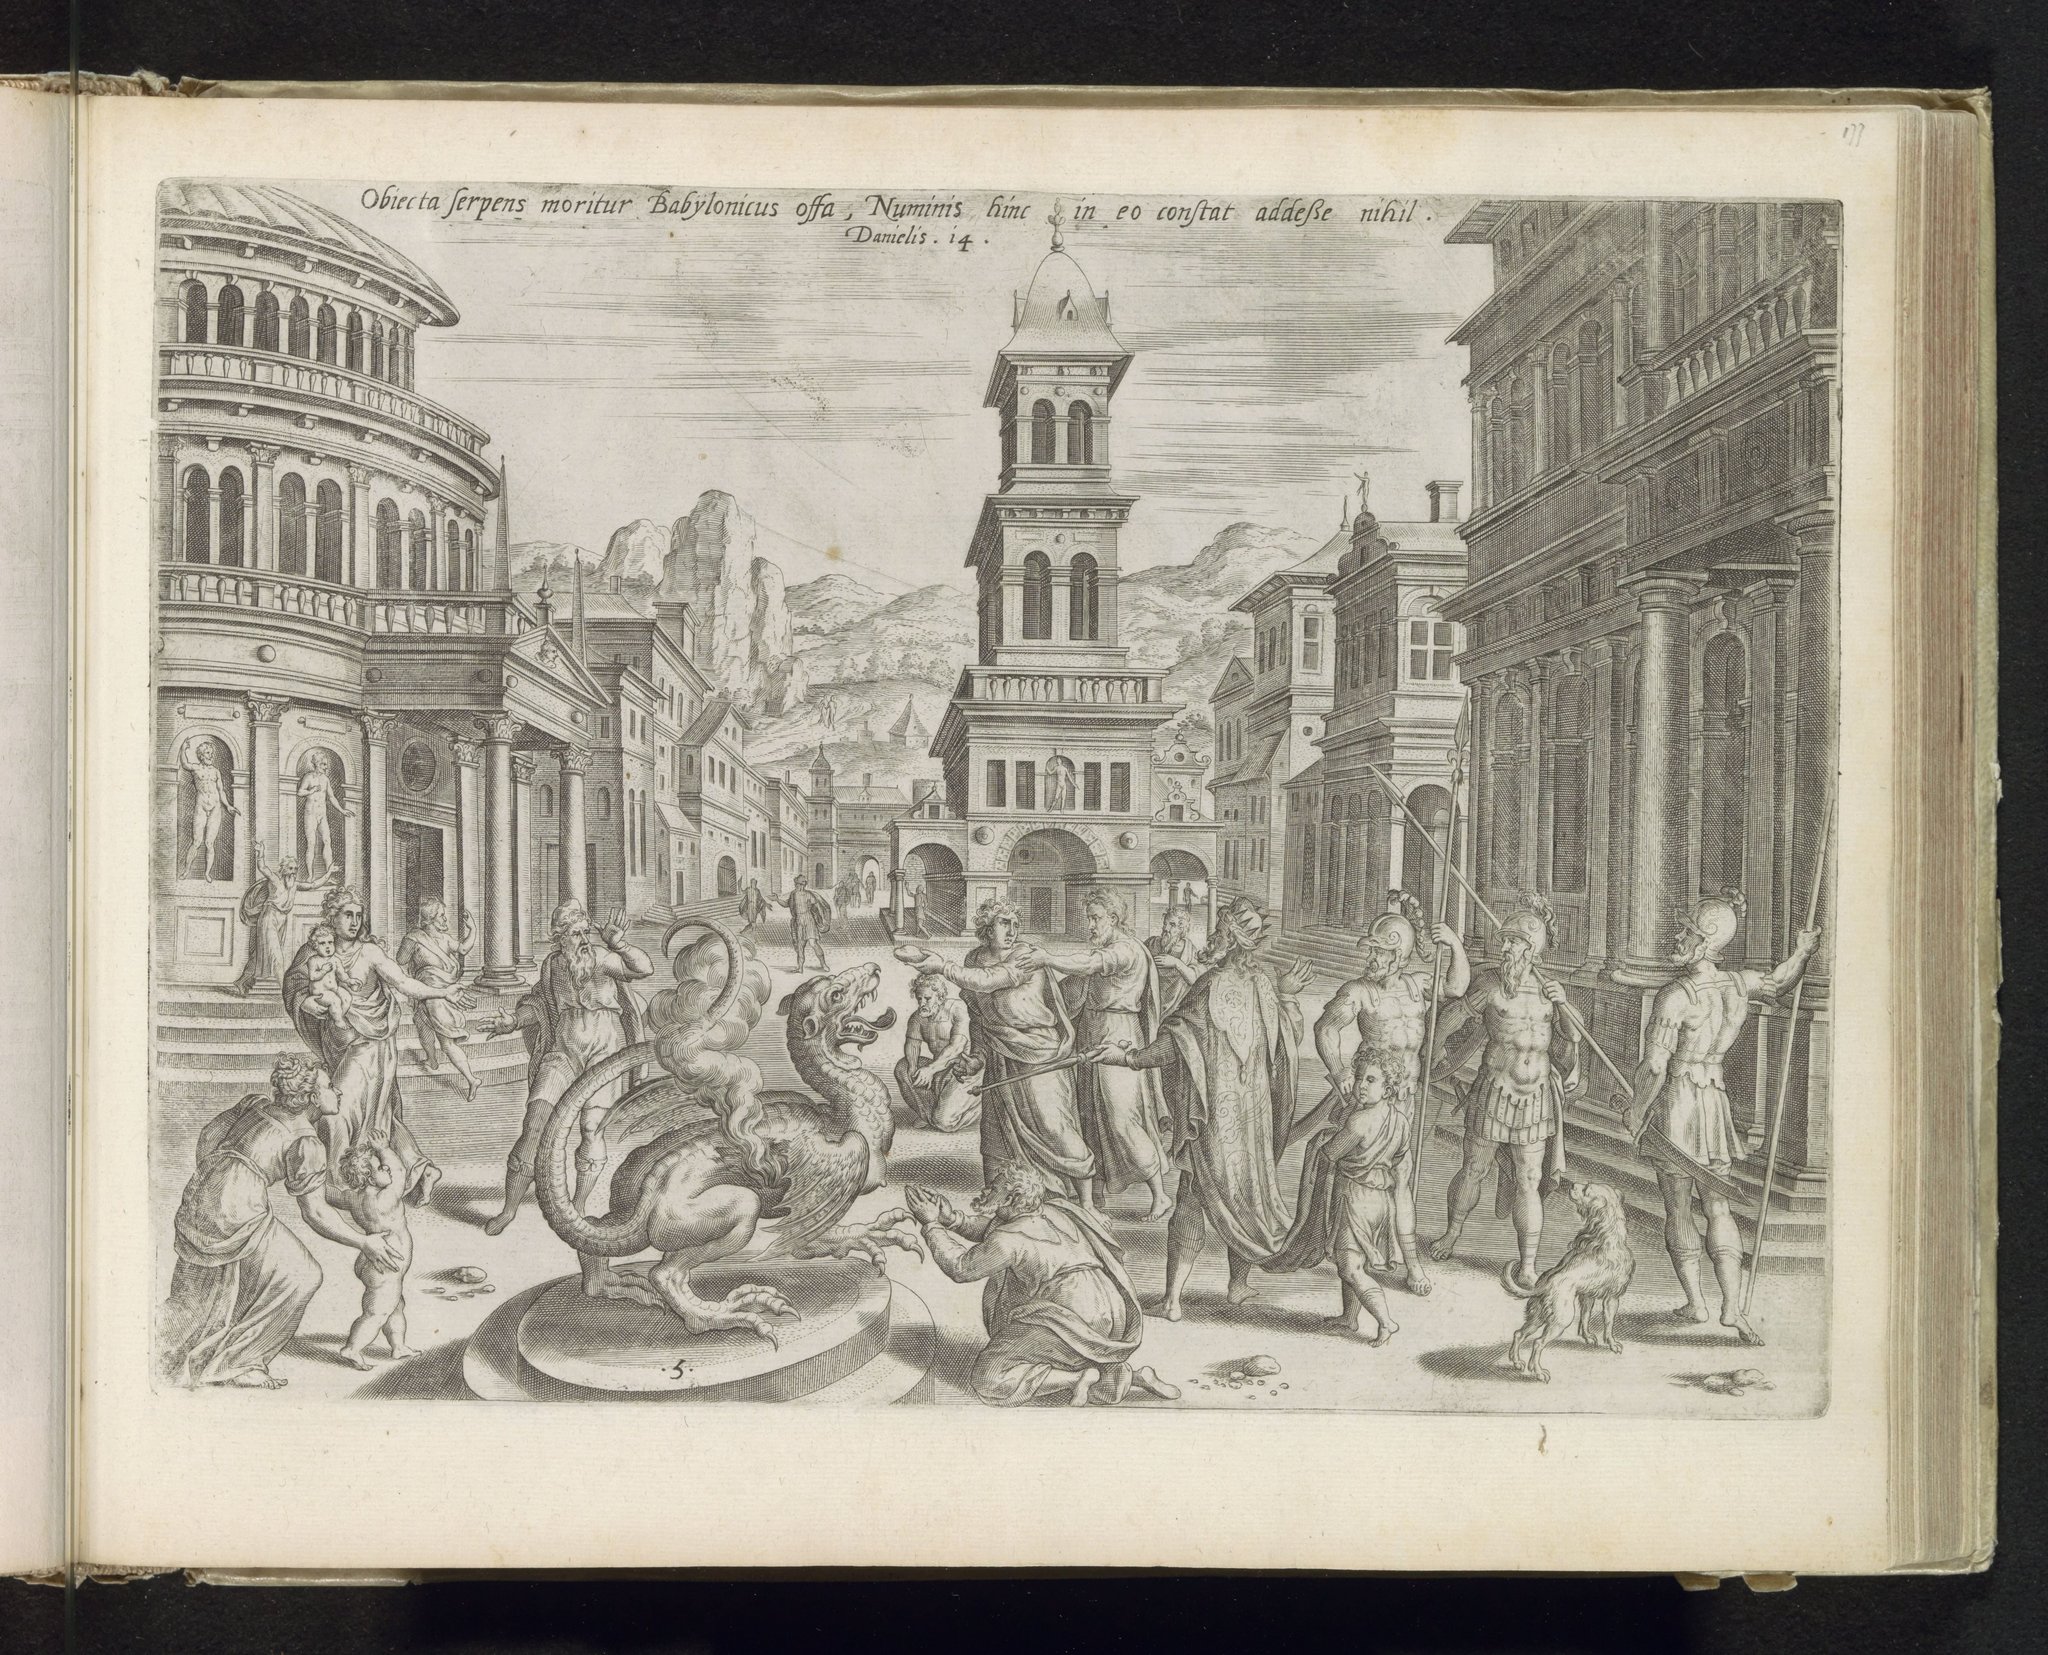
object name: print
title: Daniël en de draak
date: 1585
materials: paper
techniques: engraving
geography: antwerp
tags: daniel gives food to the dragon; king cyrus looking on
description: Daniël staat met koning Cyrus bij de draak van Babylon, die door het Babylonische volk aanbeden wordt. Daniël weigert de draak te aanbidden en vraagt aan de koning om toestemming om de draak zonder zwaard of stok te doden. Daniël staat klaar om de draak een koek van vet, teer en graten te voeren. Daardoor zal de draak vanbinnen opengereten worden en sterven. Boven de voorstelling een verwijzing in het Latijn naar de Bijbeltekst in Dan. 14. Deze prent maakt deel uit van een album.